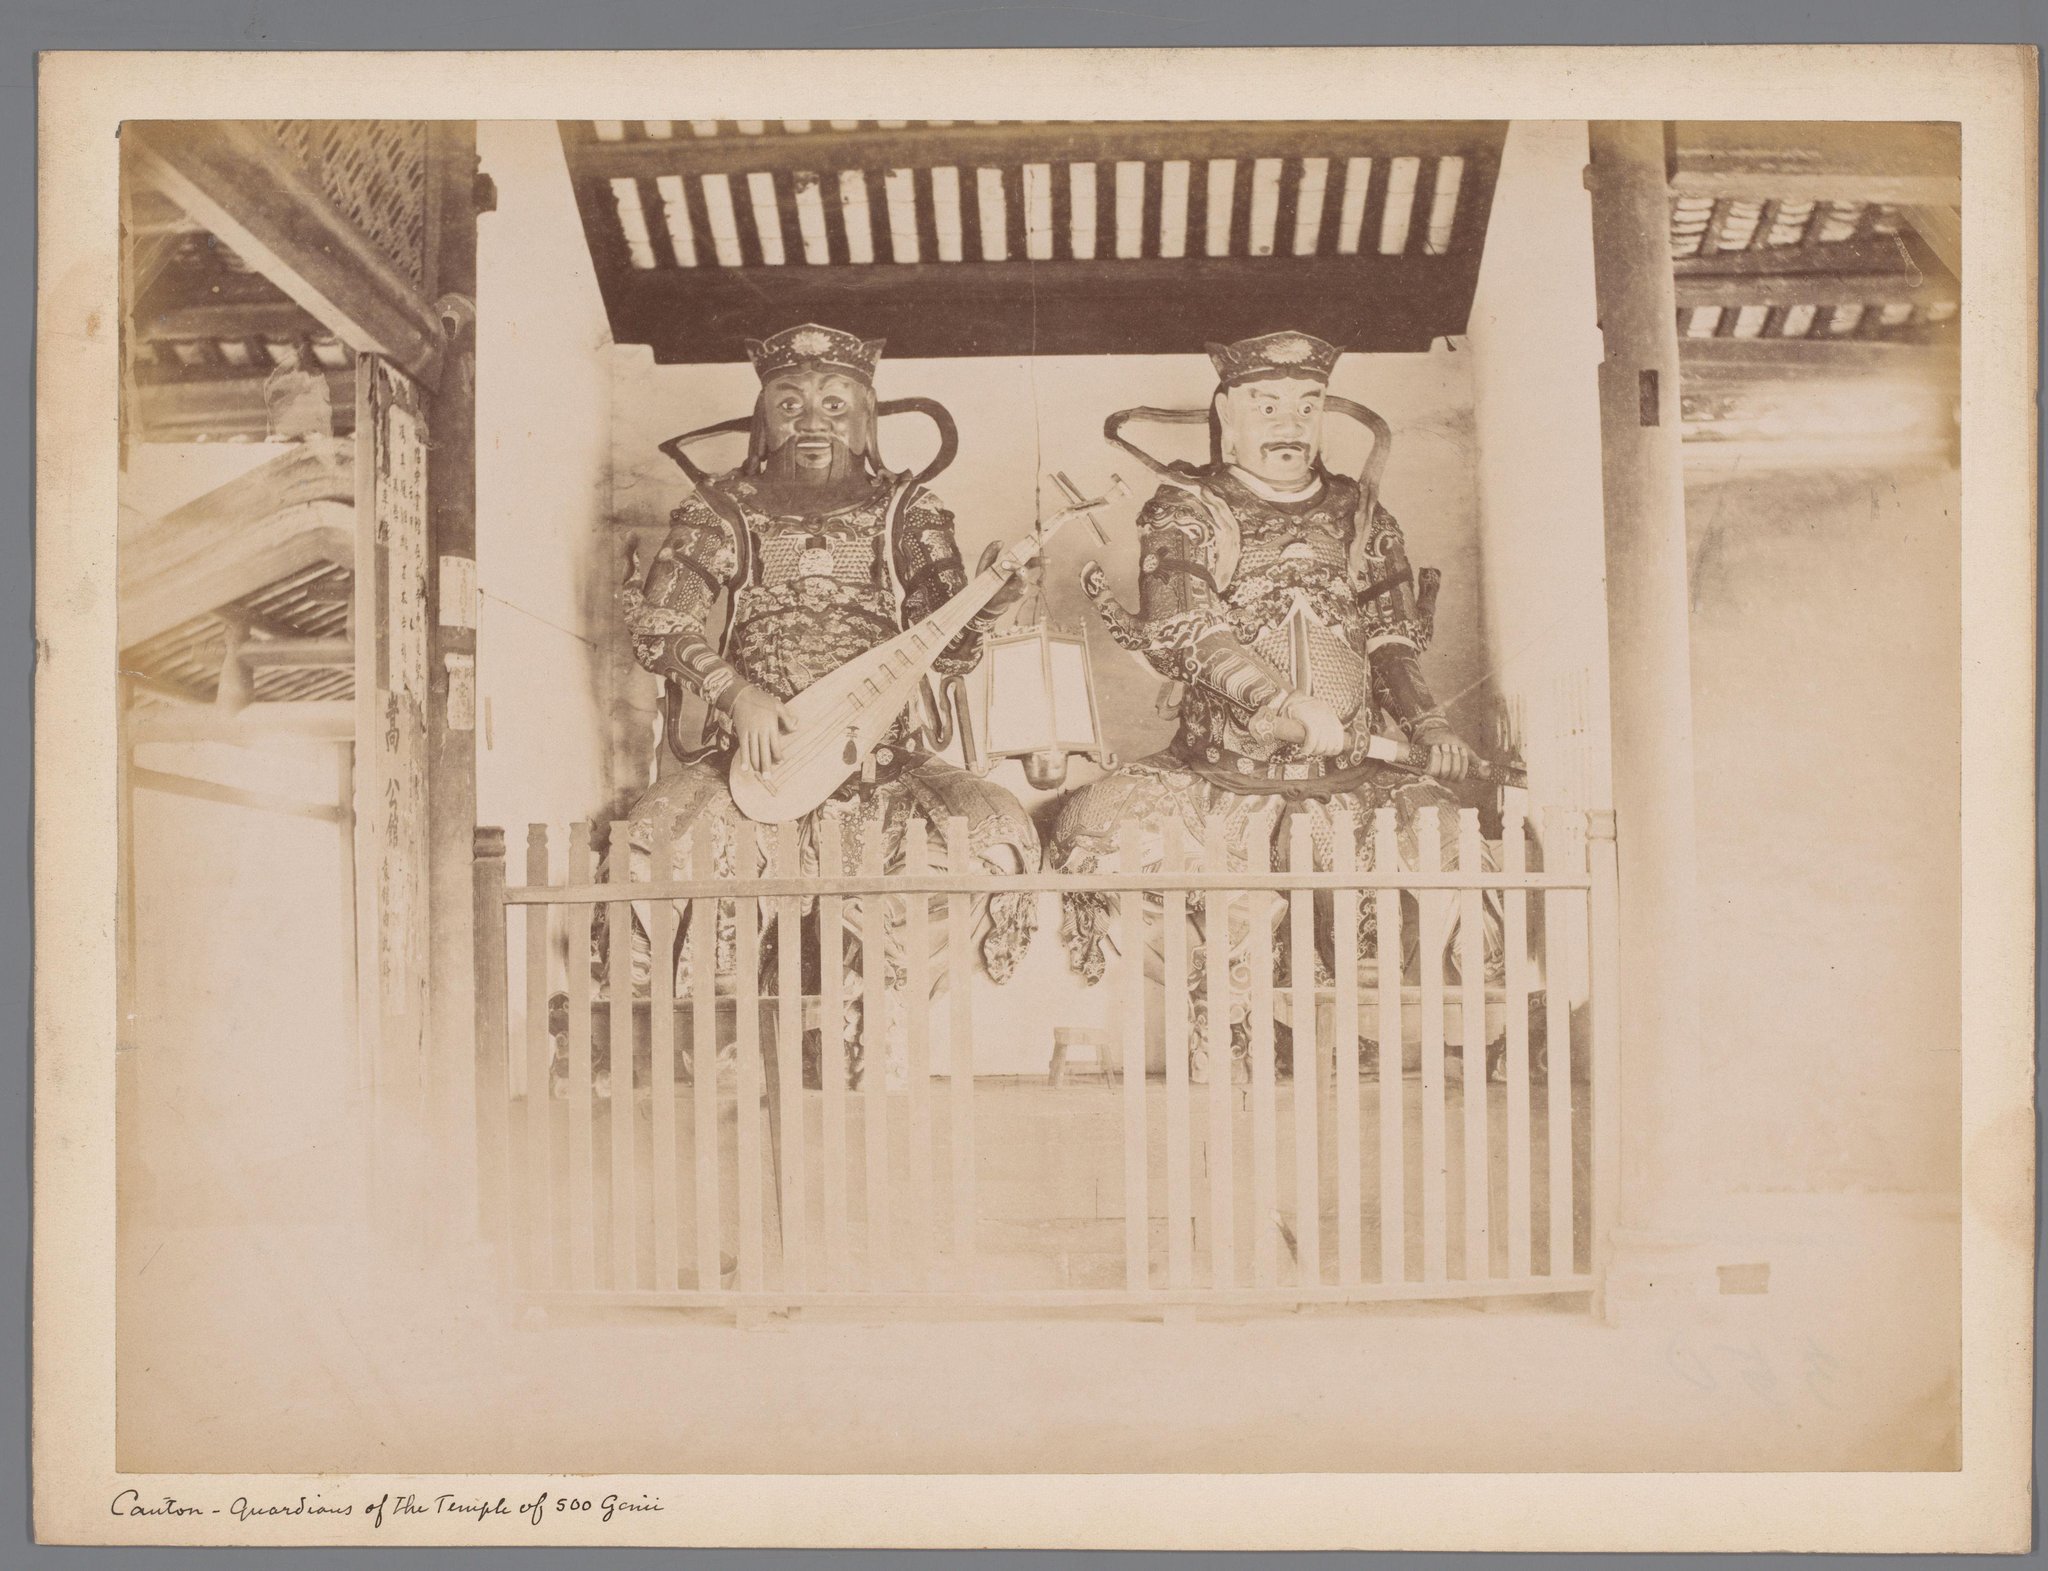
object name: photograph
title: Twee wachters van de Hualintempel van Guangzhou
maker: Anonymous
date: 1850-1900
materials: cardboard, photographic support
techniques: albumen print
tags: temple, shrine ~ traditional chinese religions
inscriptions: annotation: ‘Canton-Guardians of the Temple of 500 Genii’